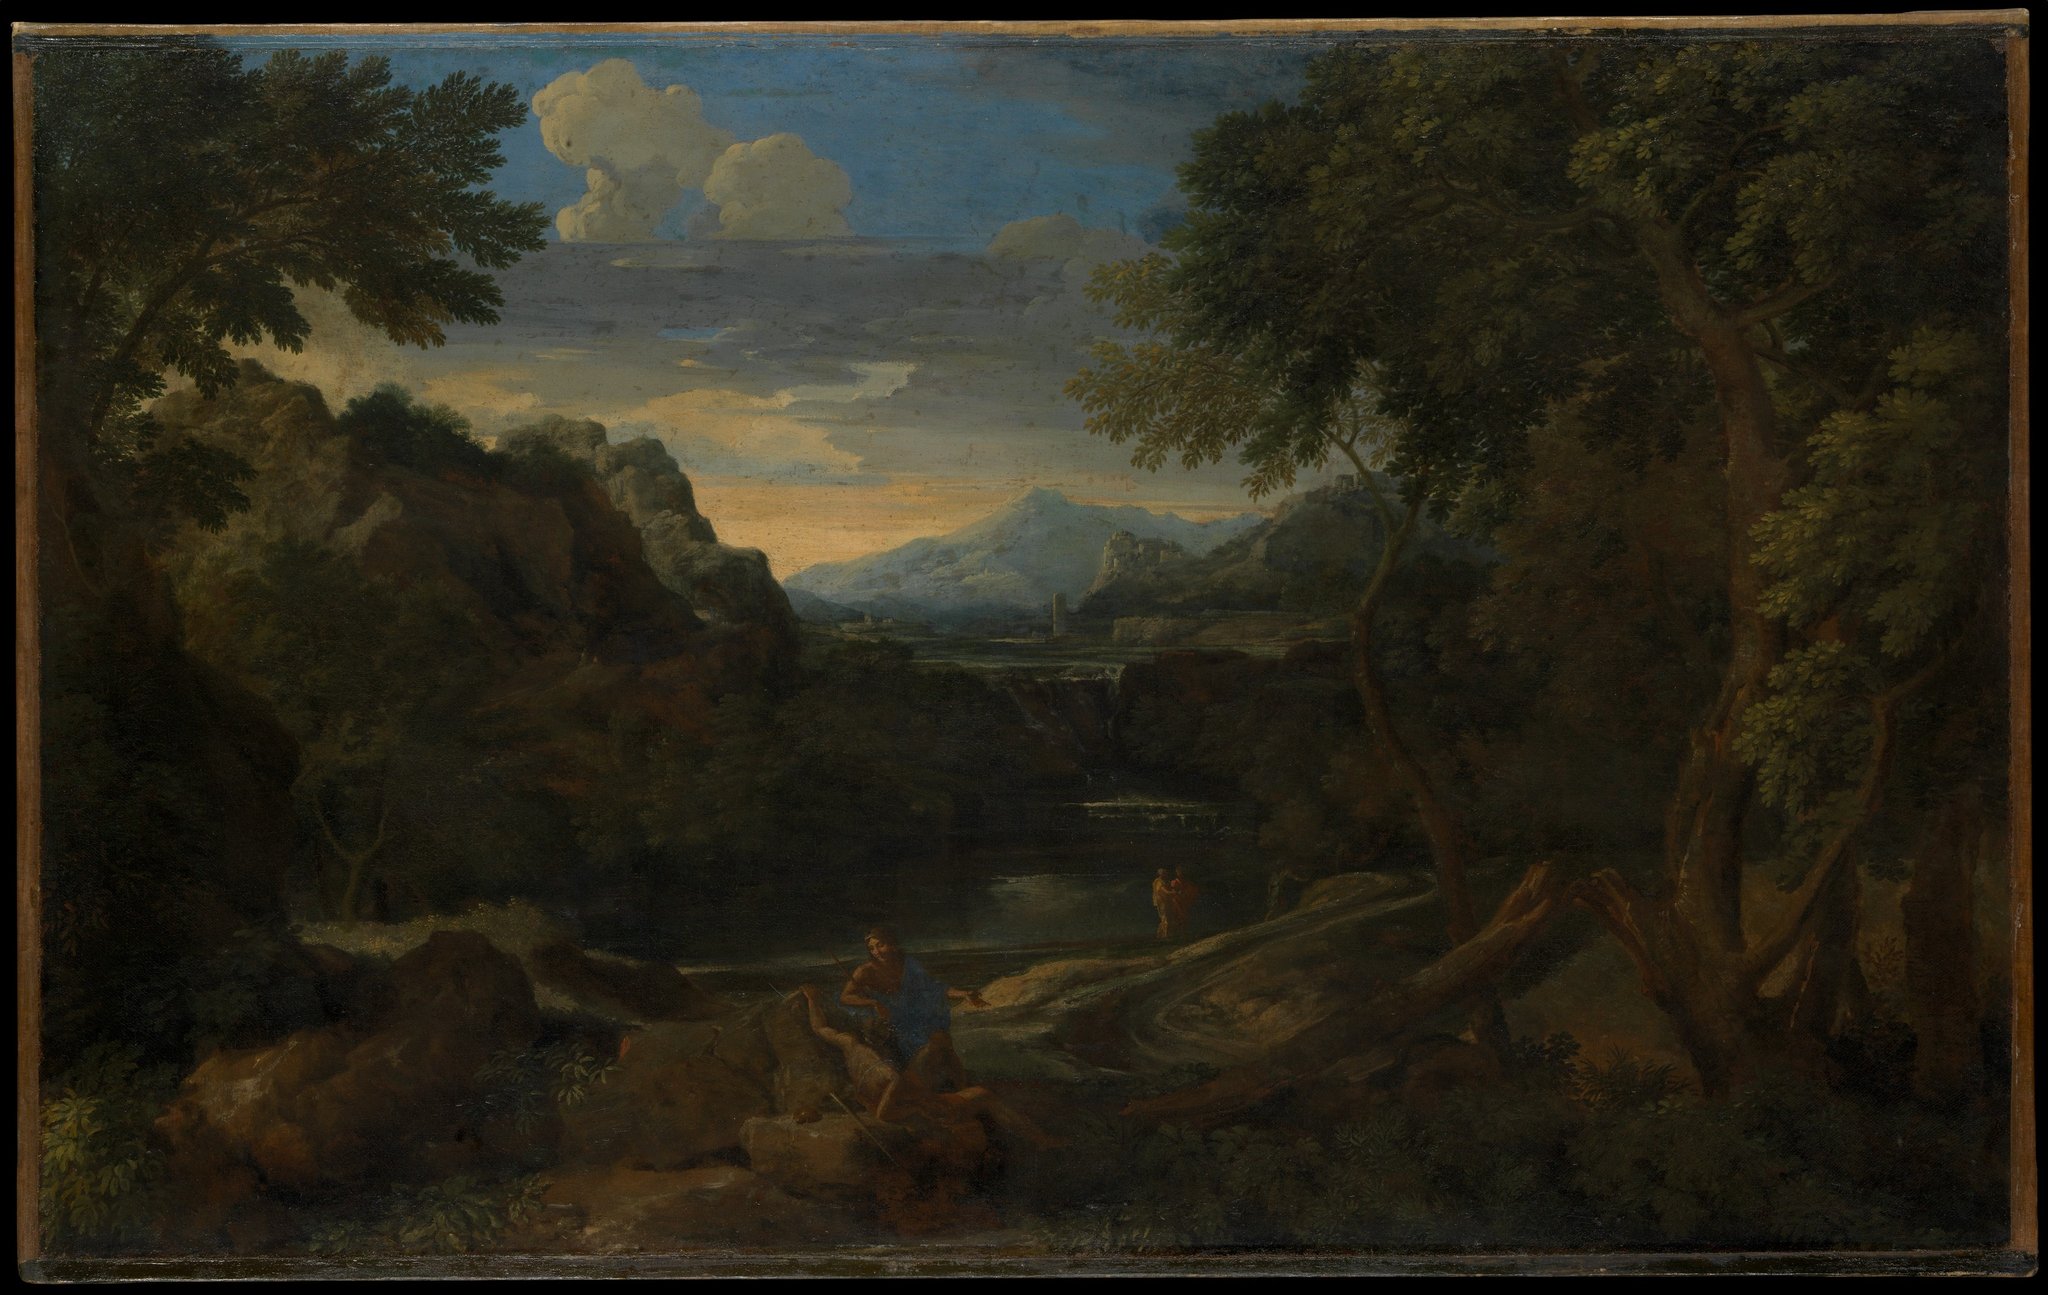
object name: painting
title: Imaginary Landscape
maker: gaspard dughet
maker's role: artist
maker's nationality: french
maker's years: 1615-1675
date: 1635-1675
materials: canvas, oil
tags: men,forests,landscapes